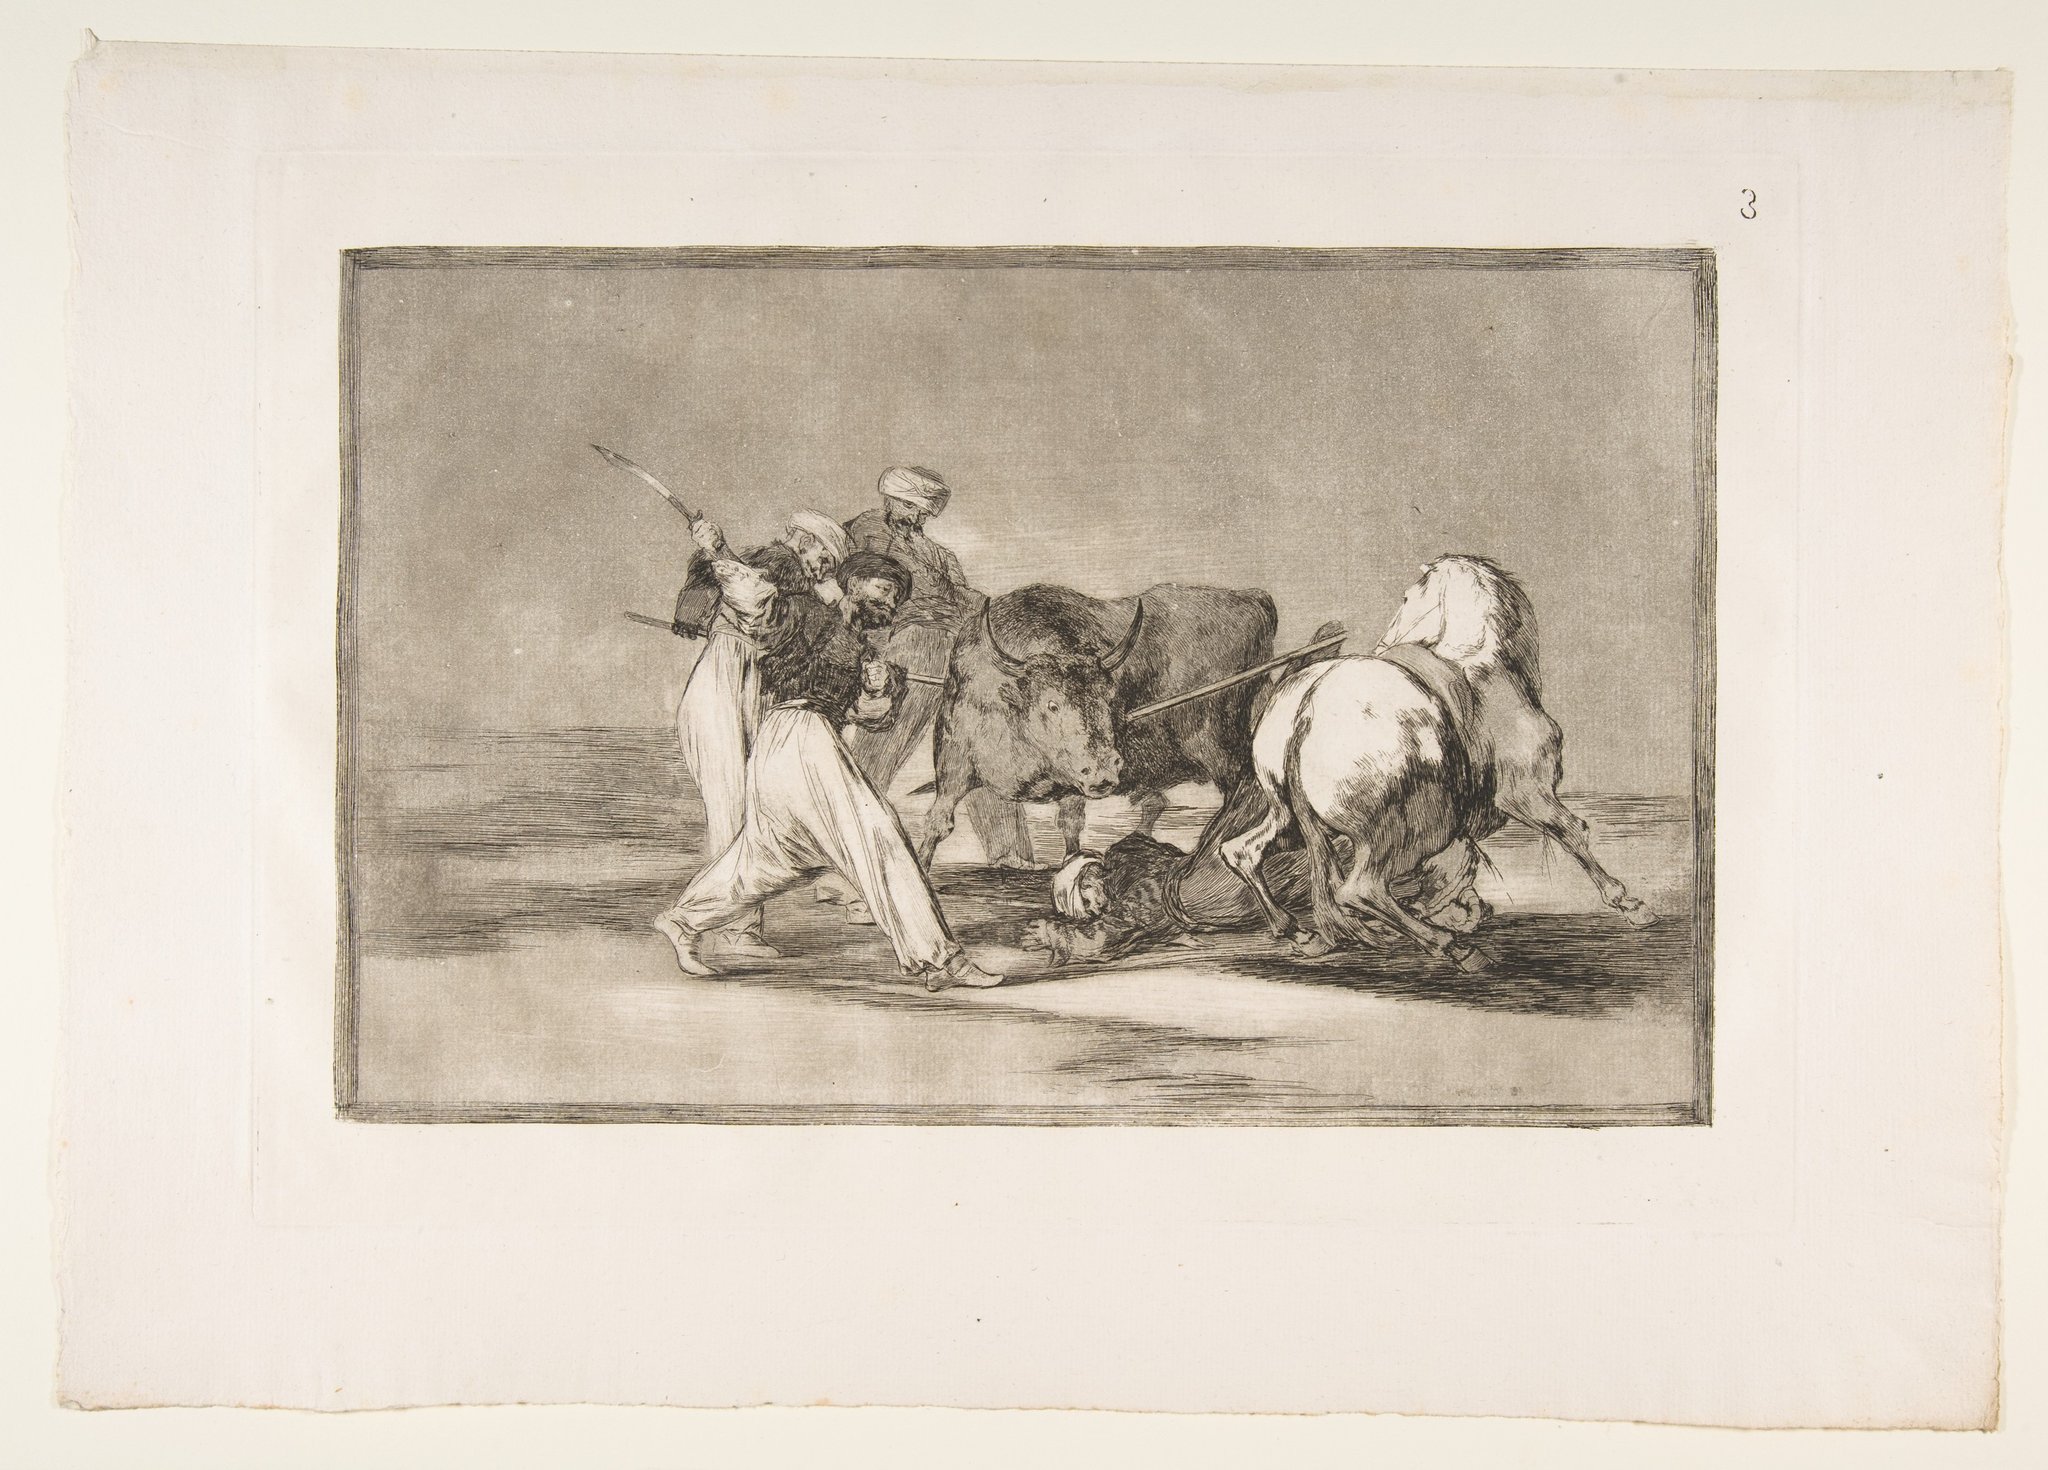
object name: print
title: Plate 3 from " La Tauromaquia": The Moors settled in Spain, giving up the superstitions of the Koran, adopted this art of hunting, and spear a bull in the open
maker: goya (francisco de goya y lucientes)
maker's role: artist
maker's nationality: spanish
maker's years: 1746-1828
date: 1816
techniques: aquatint, engraving, burnishing, drypoint, etching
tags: spears,swords,men,bulls,horses